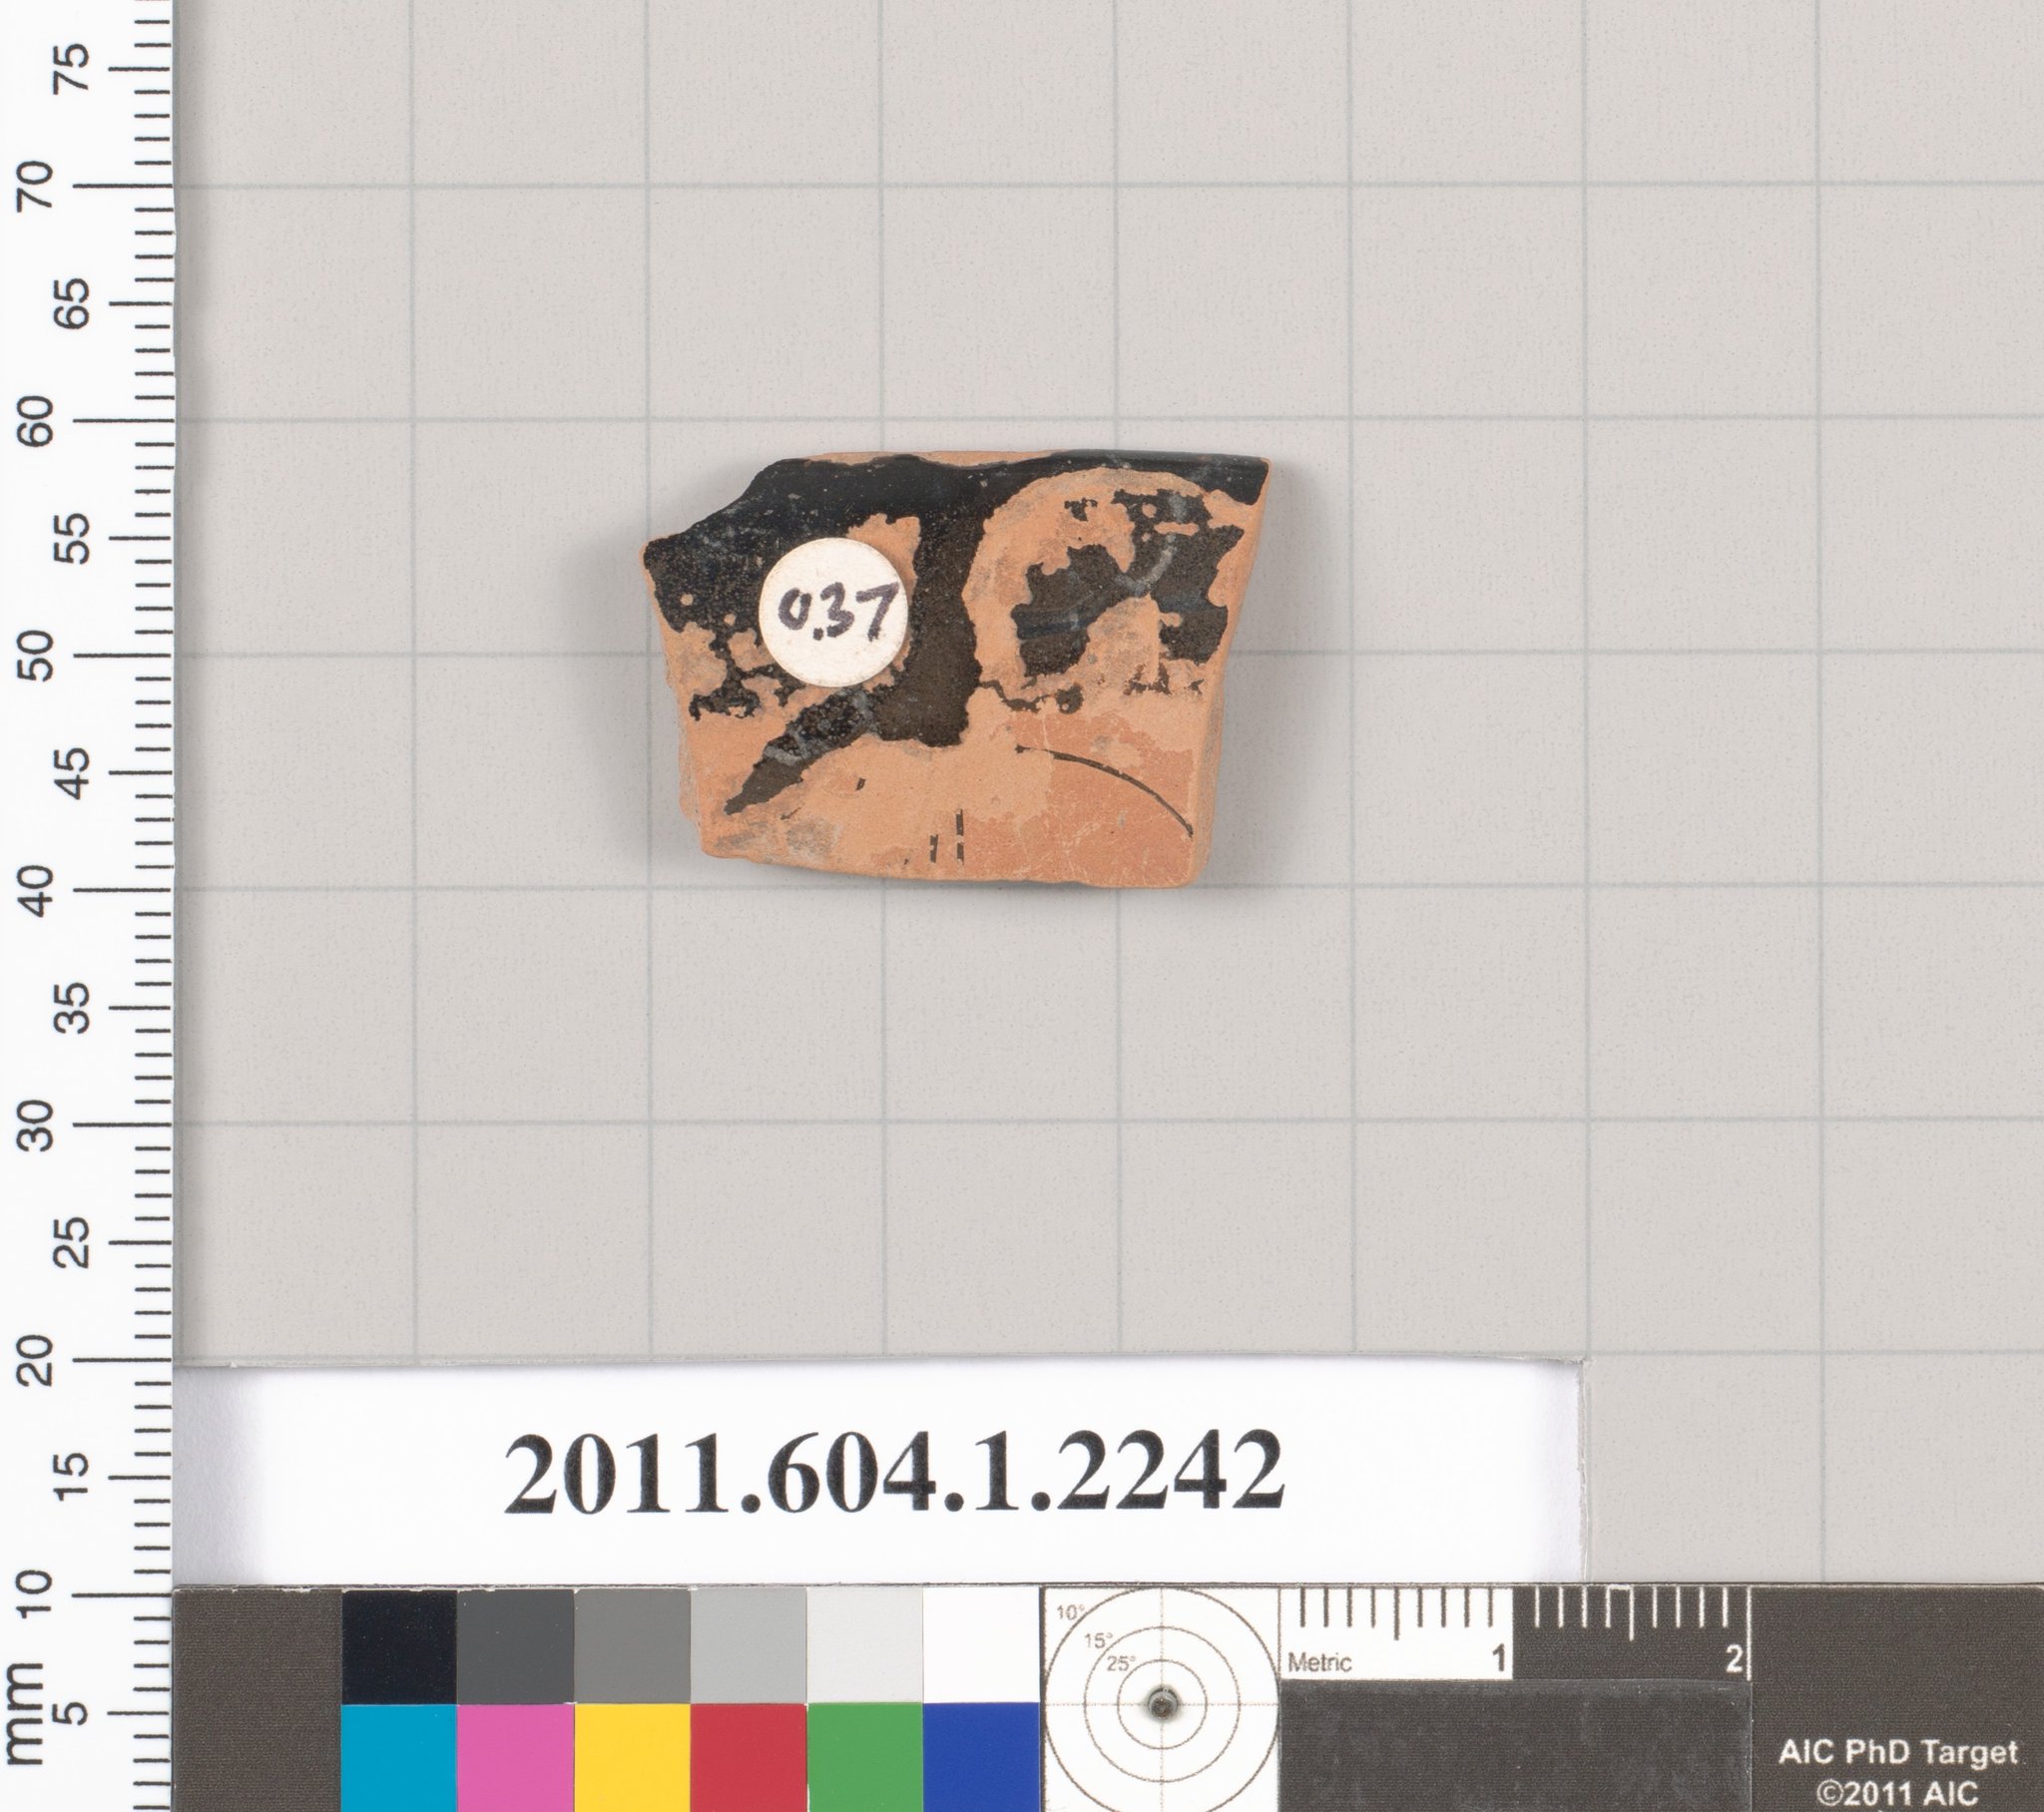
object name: kylix fragment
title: Terracotta rim fragment of a kylix (drinking cup)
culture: greek, attic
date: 475-451 BCE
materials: terracotta